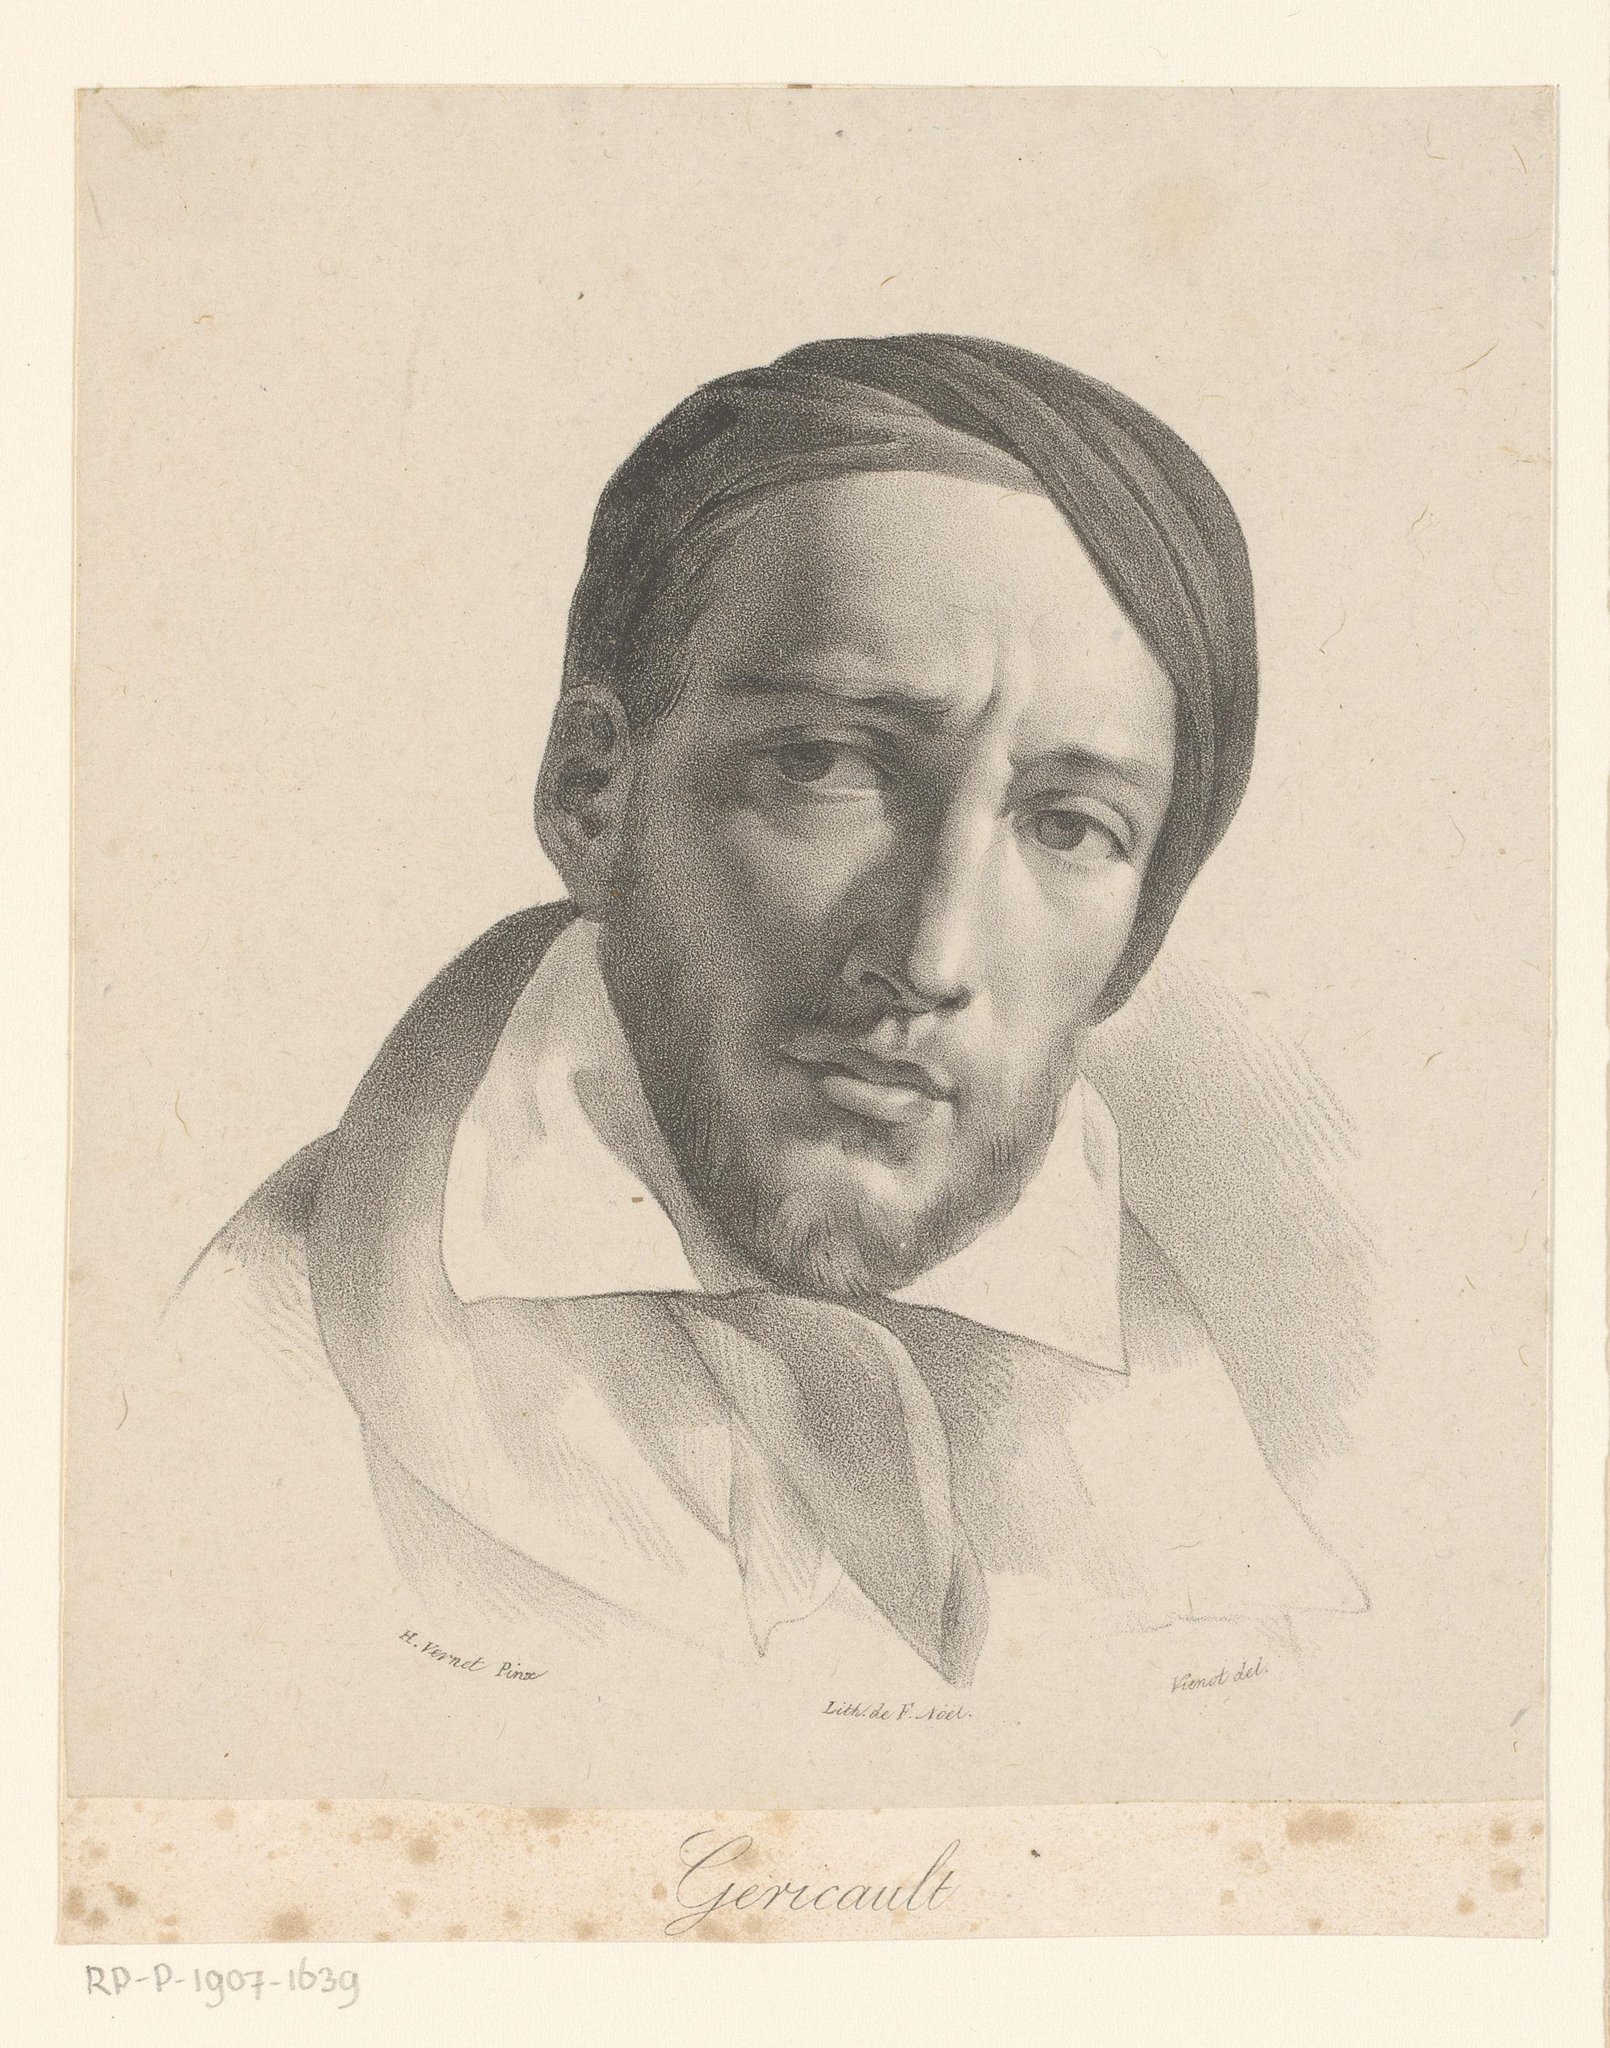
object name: print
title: Gericault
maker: horace vernet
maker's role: draughtsman, painter, print maker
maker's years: 1789-1863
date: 1824-1827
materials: paper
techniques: lithograph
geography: paris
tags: paris, print maker, draughtsman, théodore géricault, head-gear, historical persons, portrait, self-portrait of painter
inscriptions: collector's mark: Lugt 2228